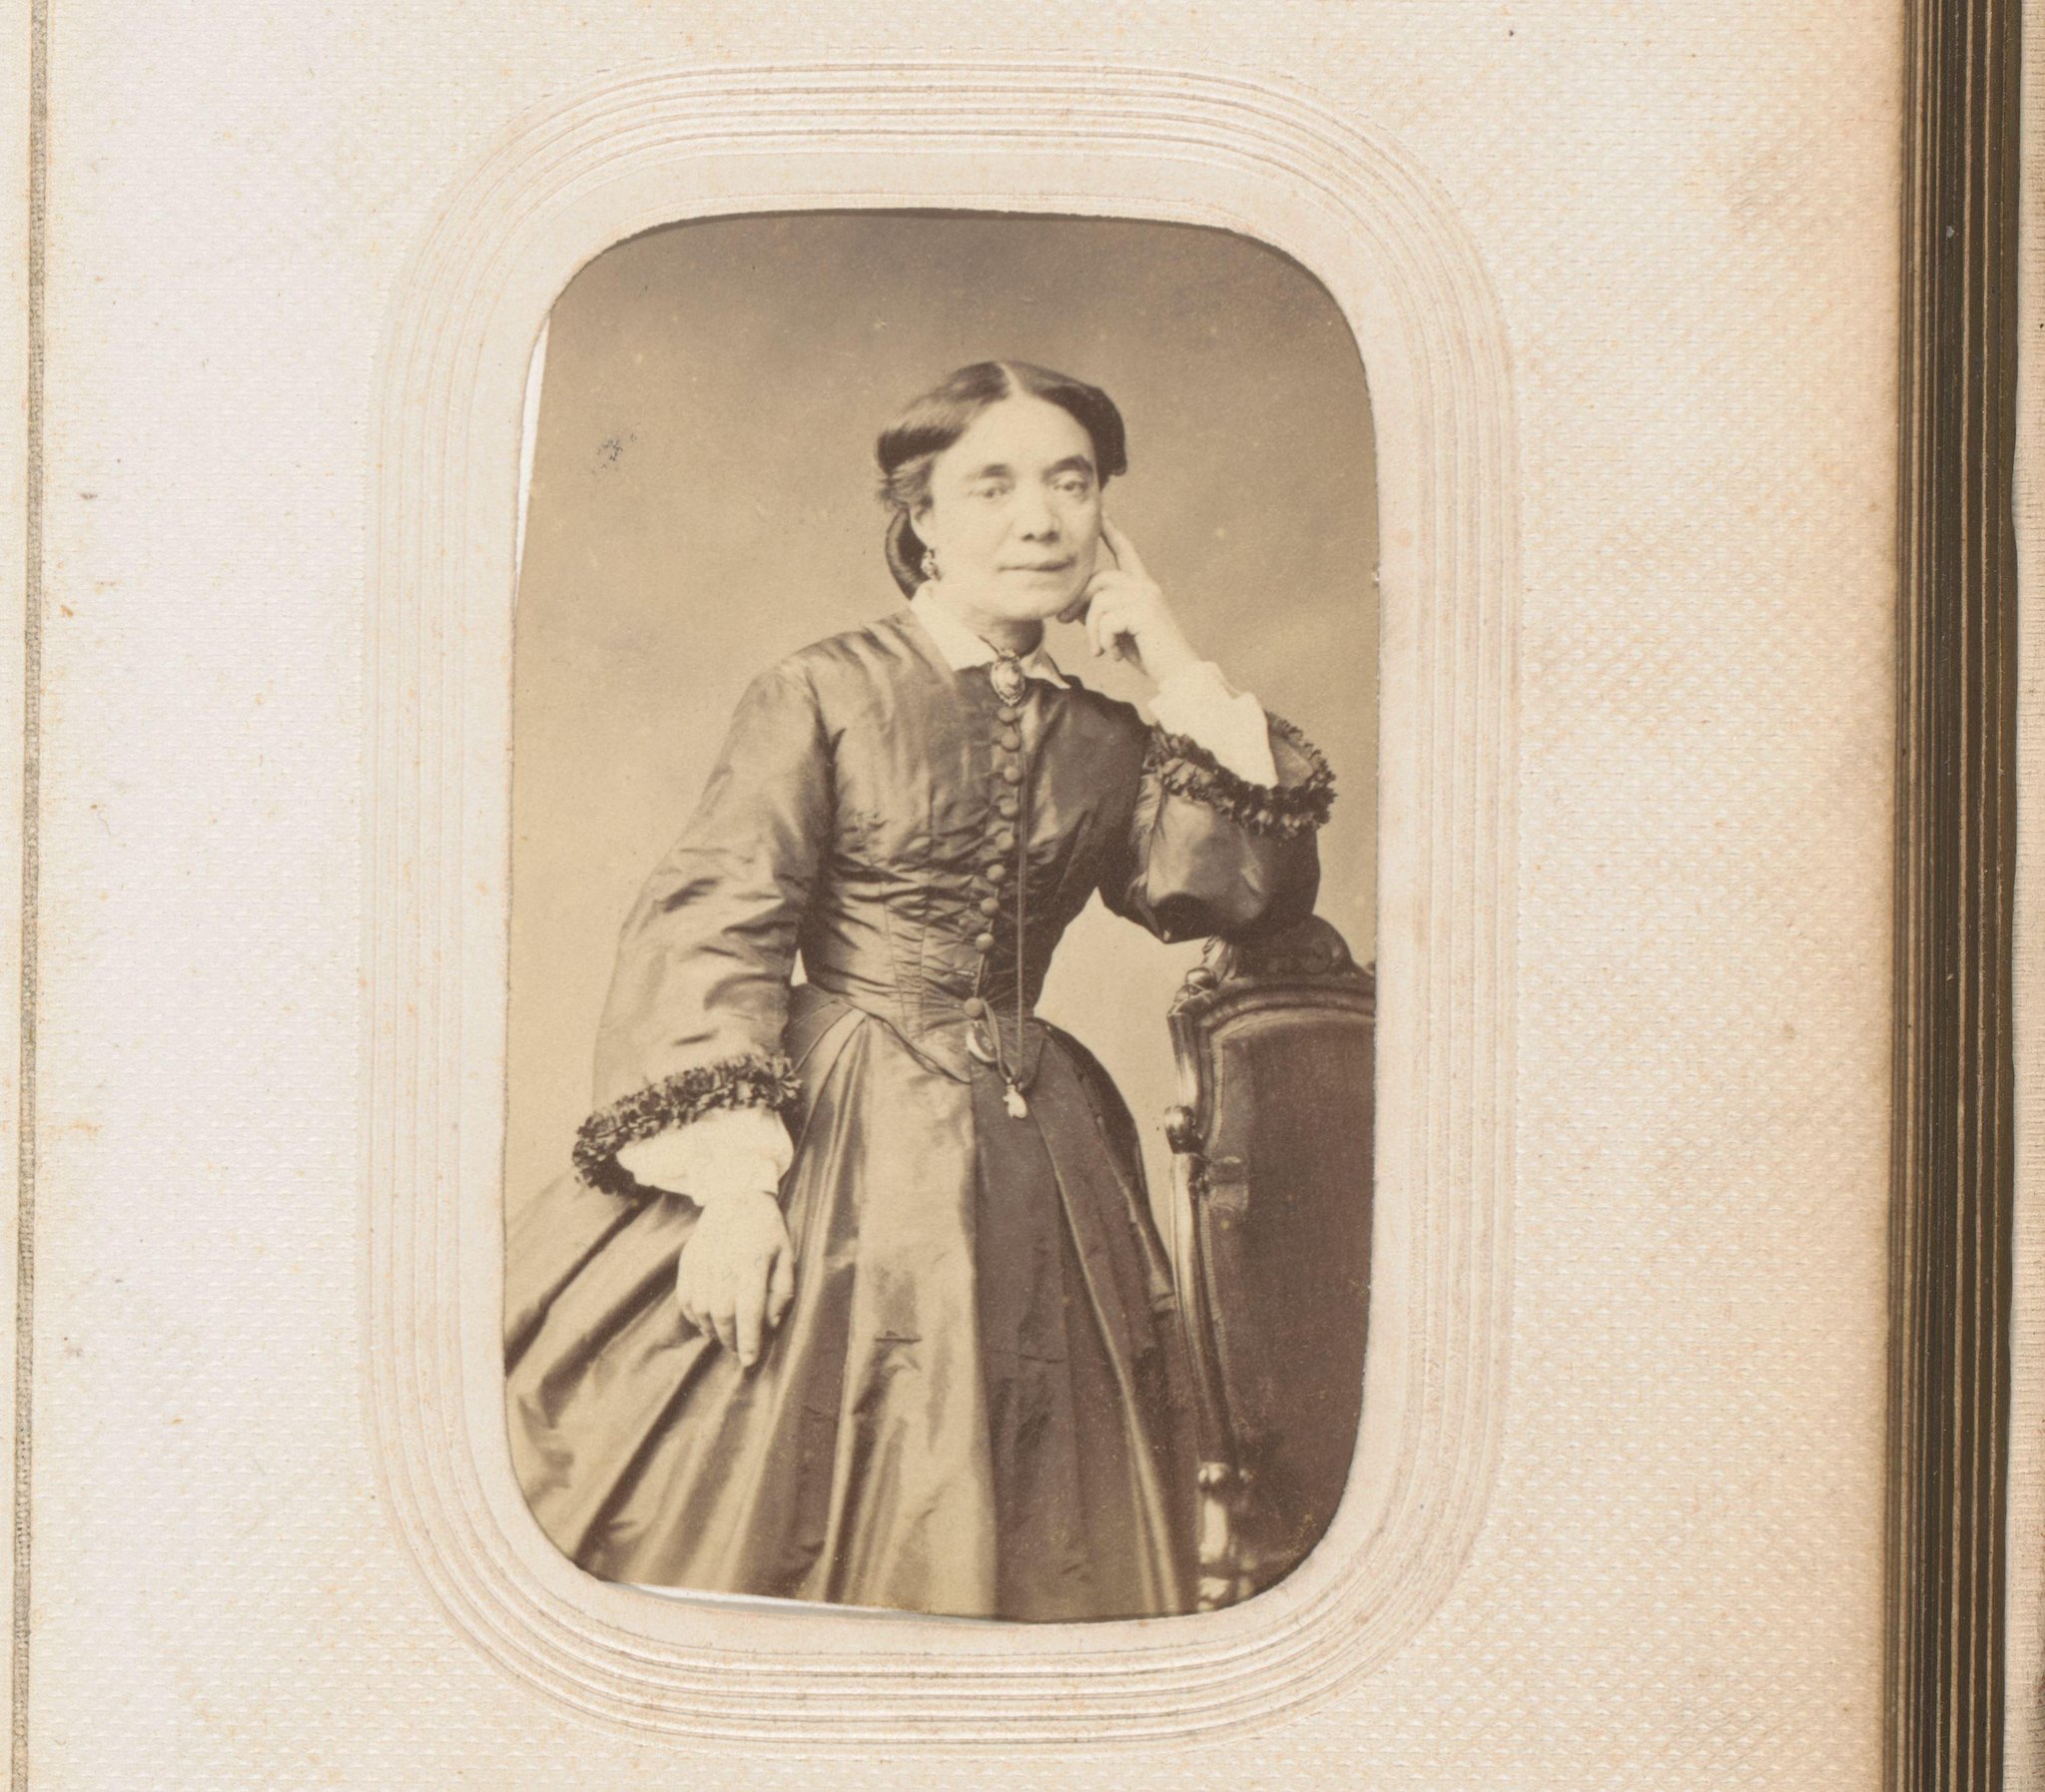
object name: album leaf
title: Portret van een staande vrouw, leunend op een stoel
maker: pierre julien calixte fourié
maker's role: fotograaf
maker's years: 1832-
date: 1855-1865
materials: cardboard, photographic support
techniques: albumen print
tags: adult woman, historical persons, chair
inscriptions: inscription: ‘28 Rue ste Catherine, Bordeaux’